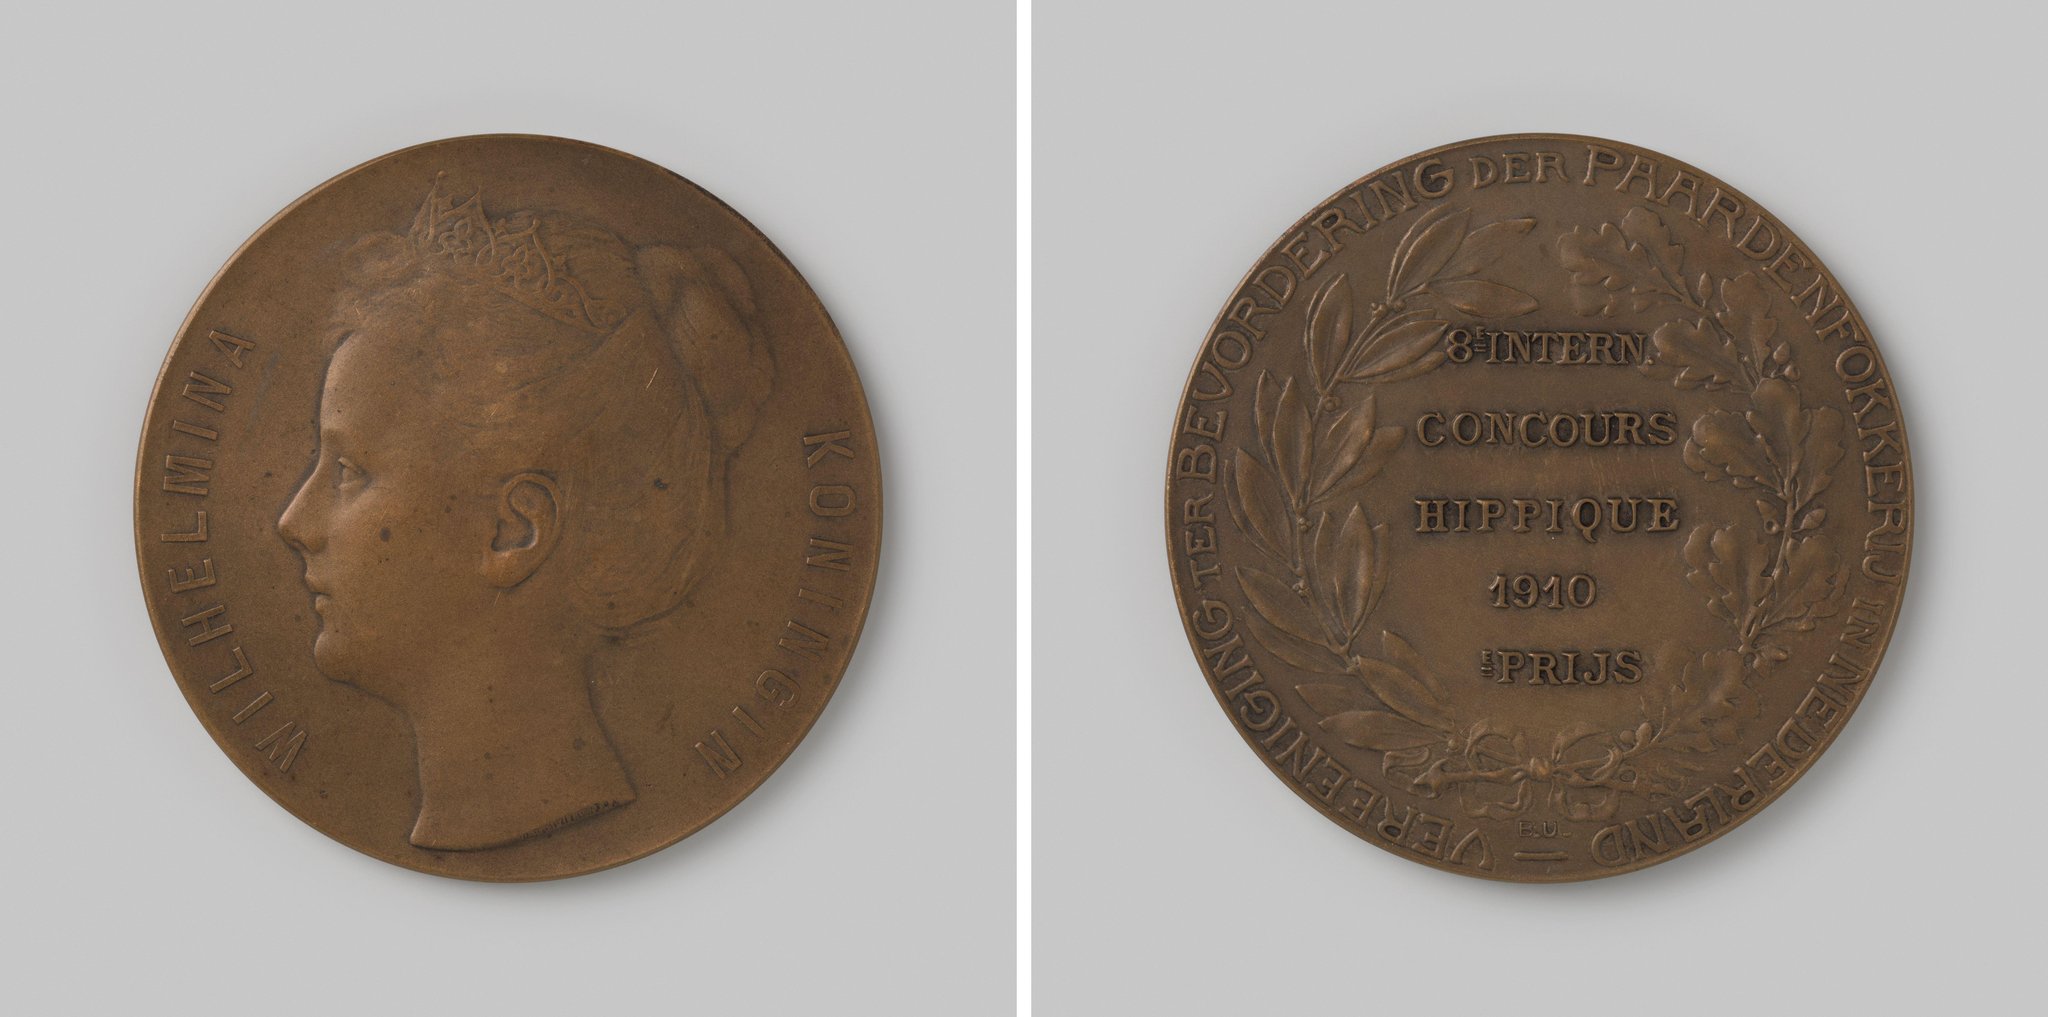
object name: history medal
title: Achtste Internationale Concours Hippique te 's-Gravenhage 1910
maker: pier pander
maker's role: designer, draughtsman, sculptor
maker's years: 1864-1919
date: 1909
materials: bronze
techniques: striking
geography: rome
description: Bronzen penning, op de voorzijde het portret van Koningin Wilhelmina naar links met omschrift, op de keerzijde vijf regels tekst tussen samengestrikte lauwer- en eikentakken, met omschrift.